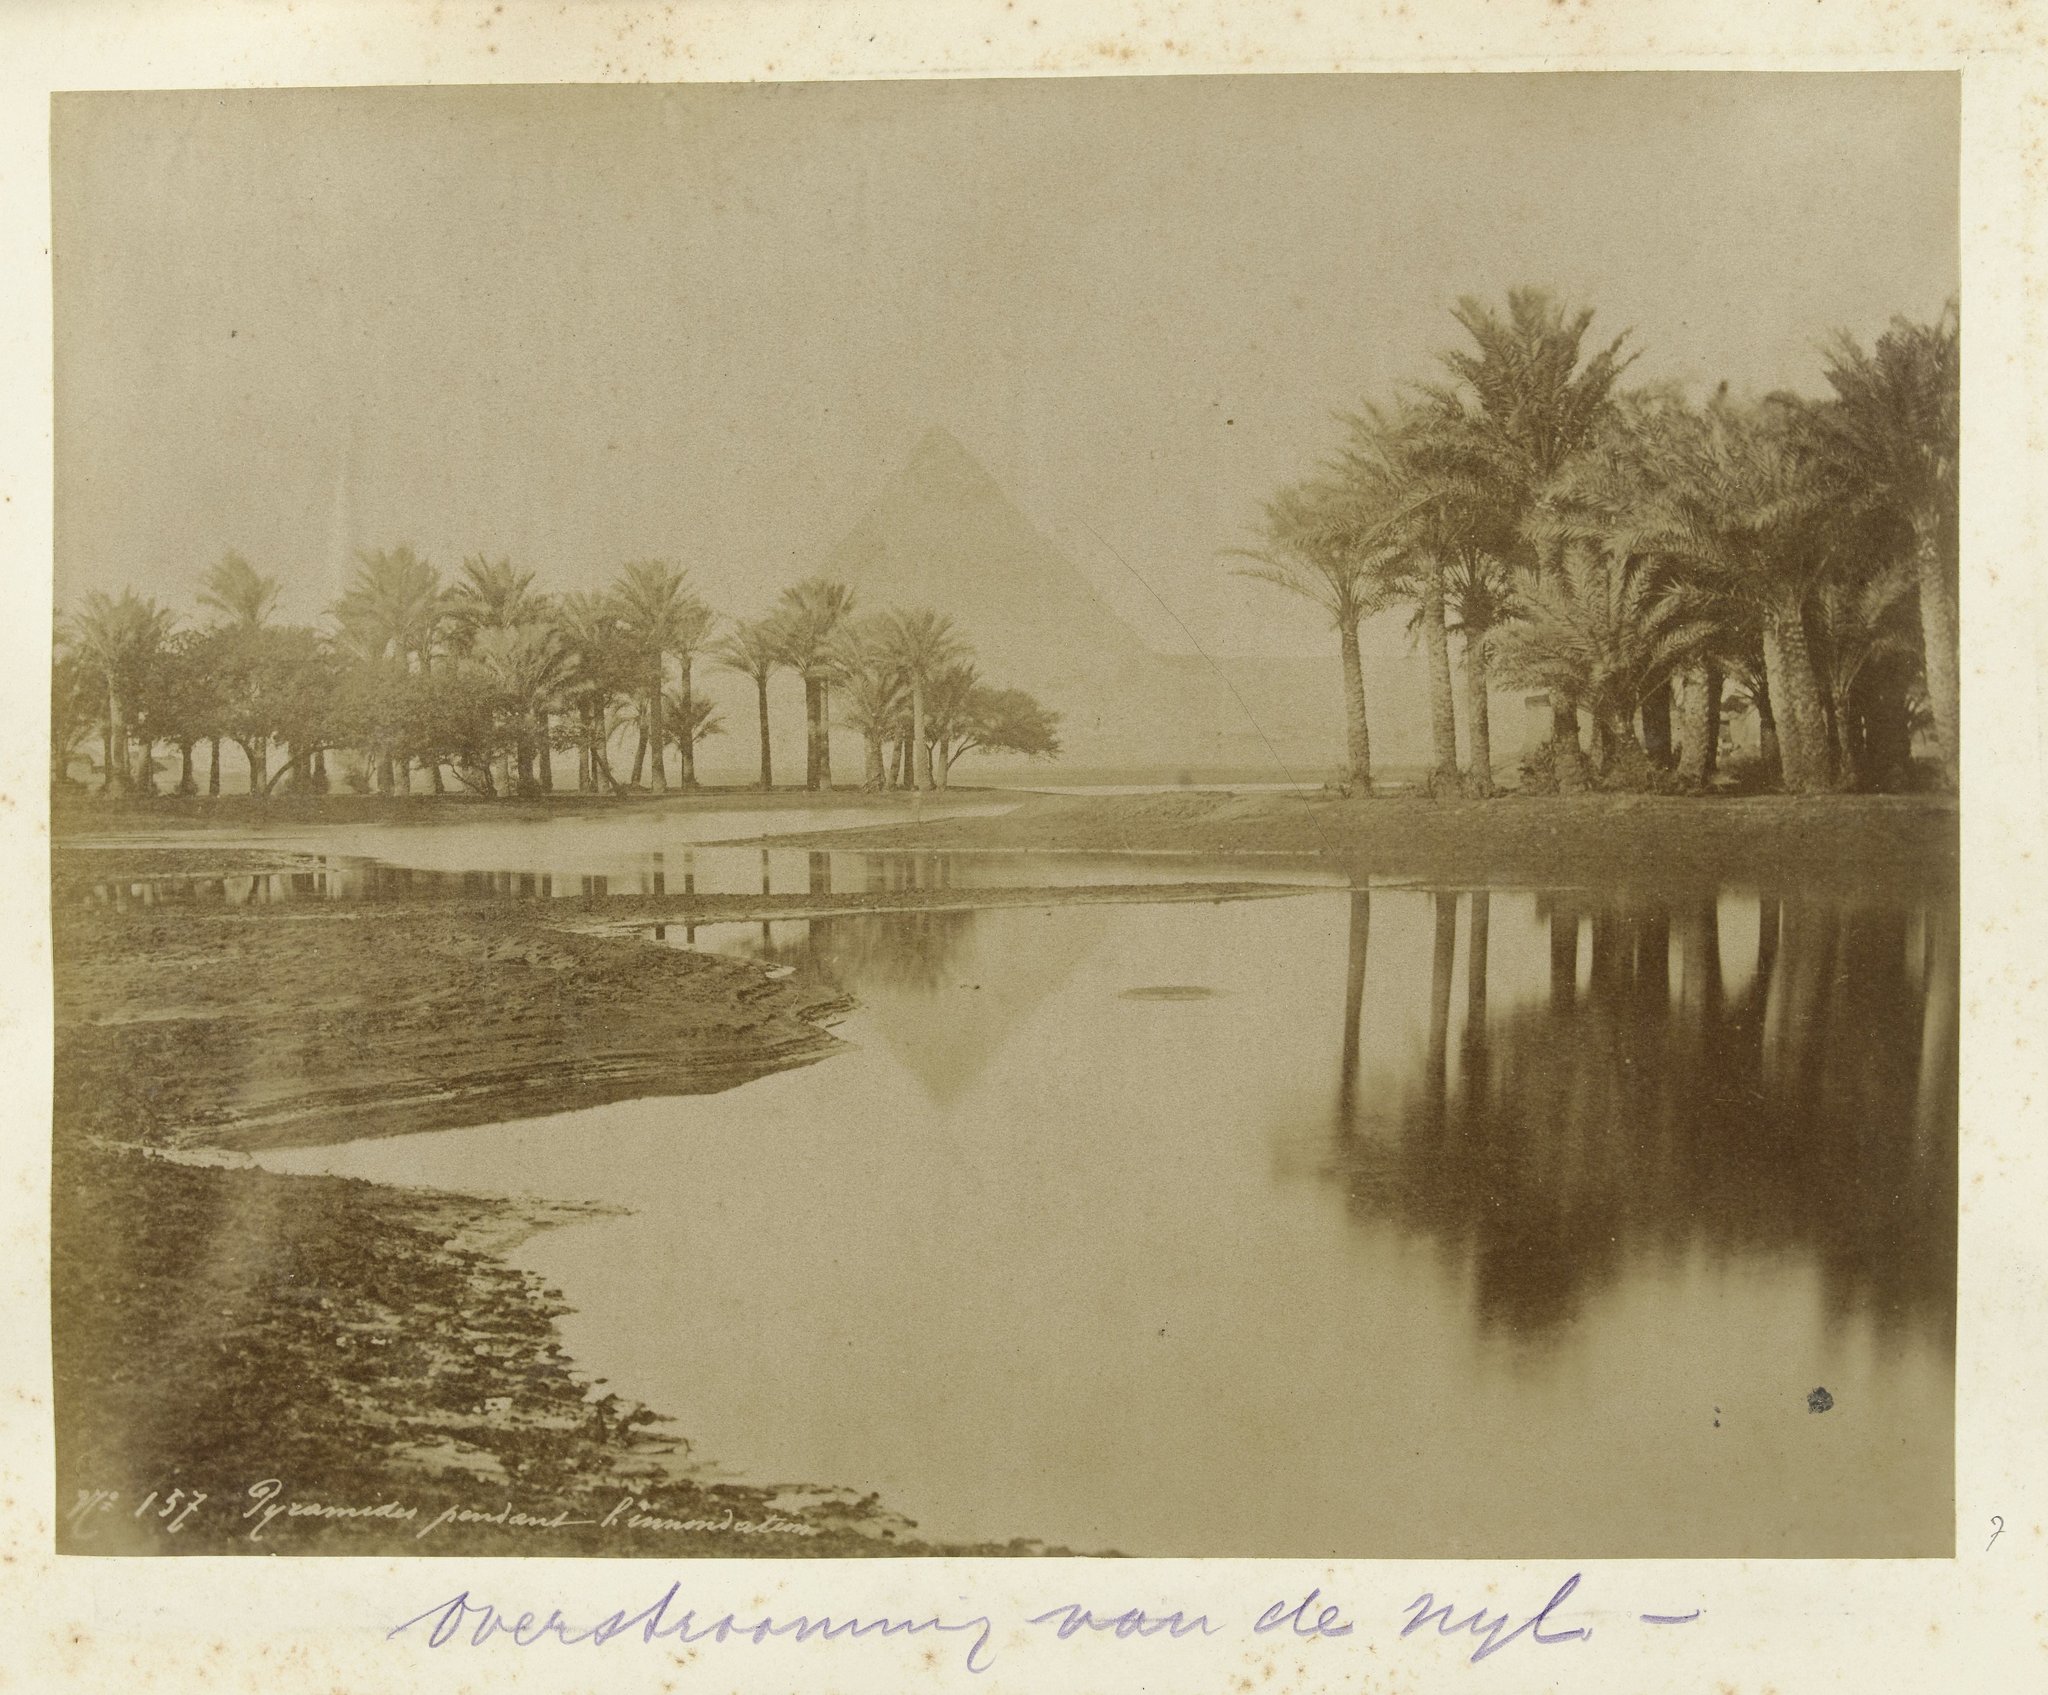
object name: photograph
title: Rivier de Nijl treedt buiten zijn oevers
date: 1890-1910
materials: cardboard, paper, photographic support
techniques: gelatin silver print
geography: netherlands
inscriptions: title: ‘No 157. Pyramides pendant l'innondation’, caption: ‘Overstrooming van de Nijl’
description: Op de achtergrond is een pyramide zichtbaar.